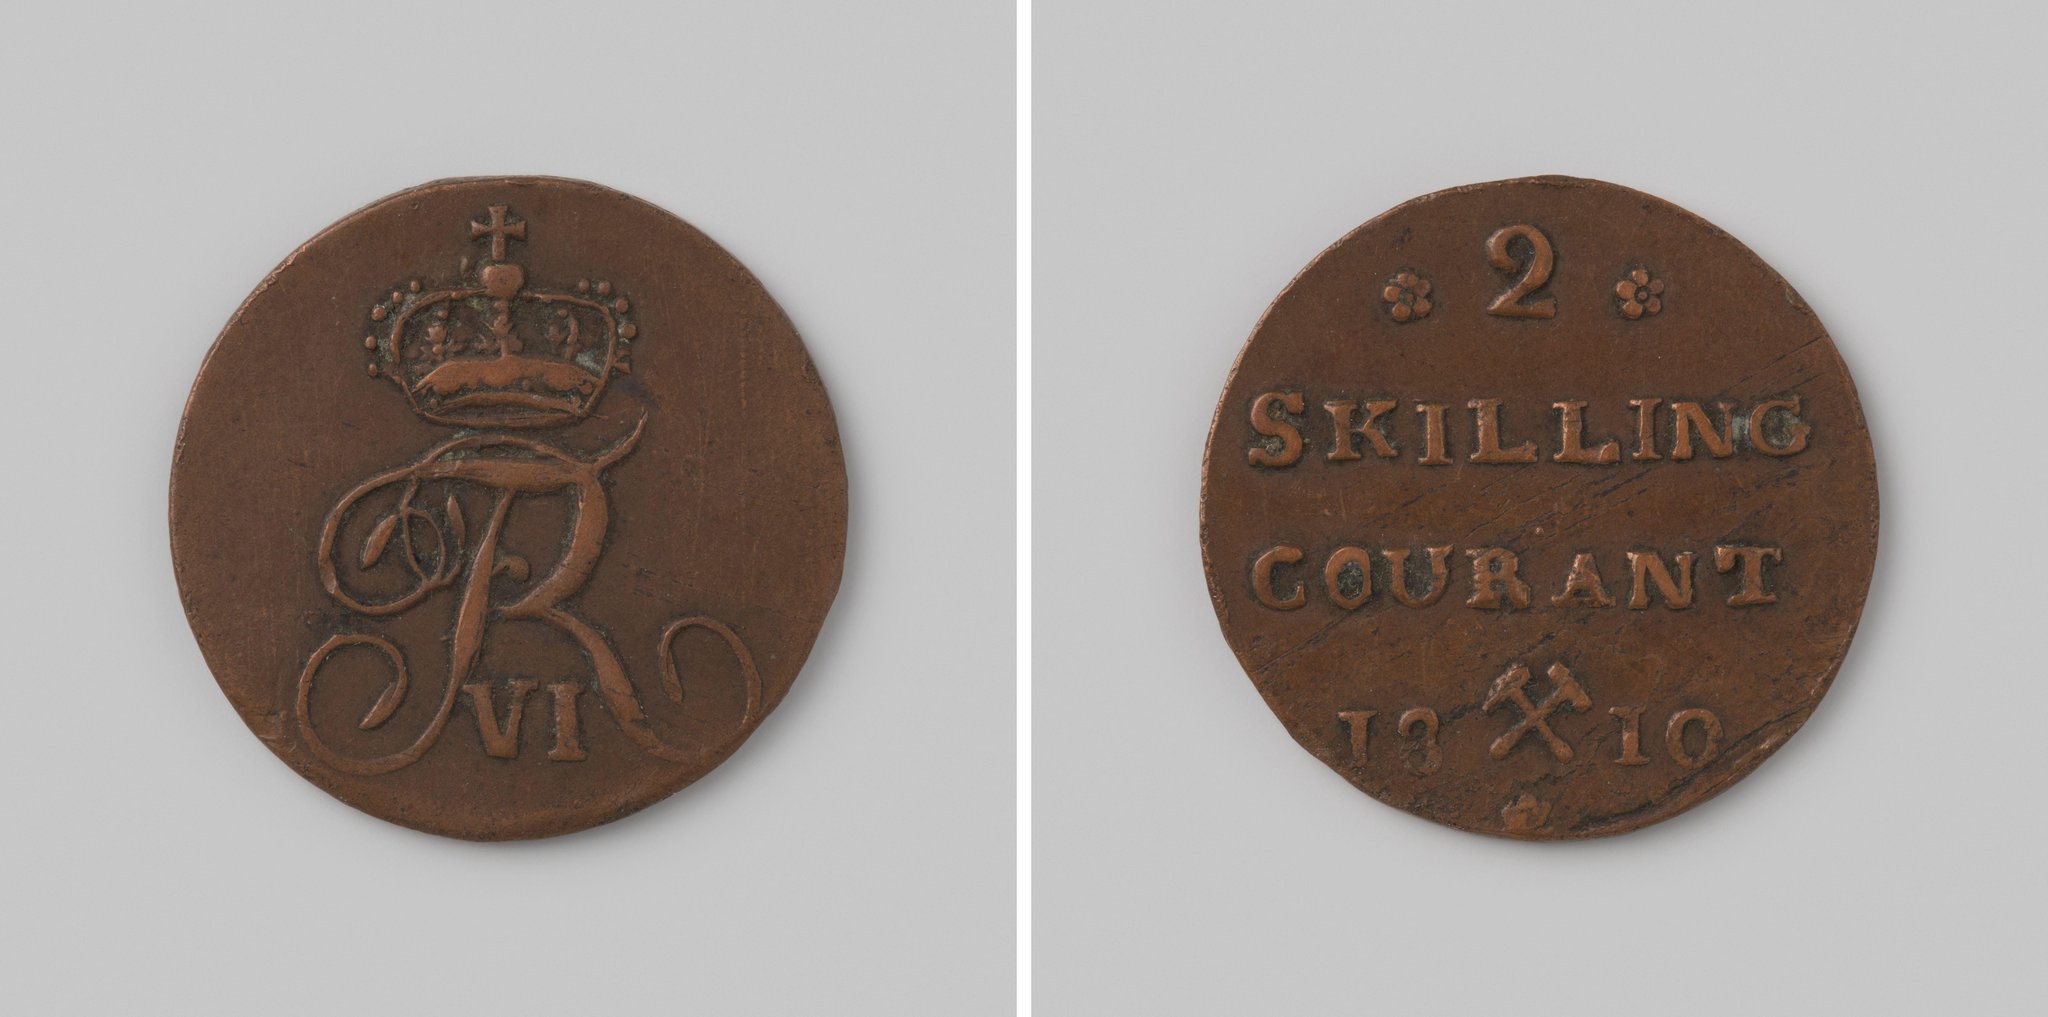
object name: coin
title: 2 skilling courant uit Noorwegen van Frederik VI, 1810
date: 1810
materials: copper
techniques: striking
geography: kongsberg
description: Koperen munt. Voorzijde: gekroond monogram van de vorst. Keerzijde: waarde-aanduiding in drie regels. Jaartal onderaan, waartussen aanduiding van de muntplaats. Gladde rand.